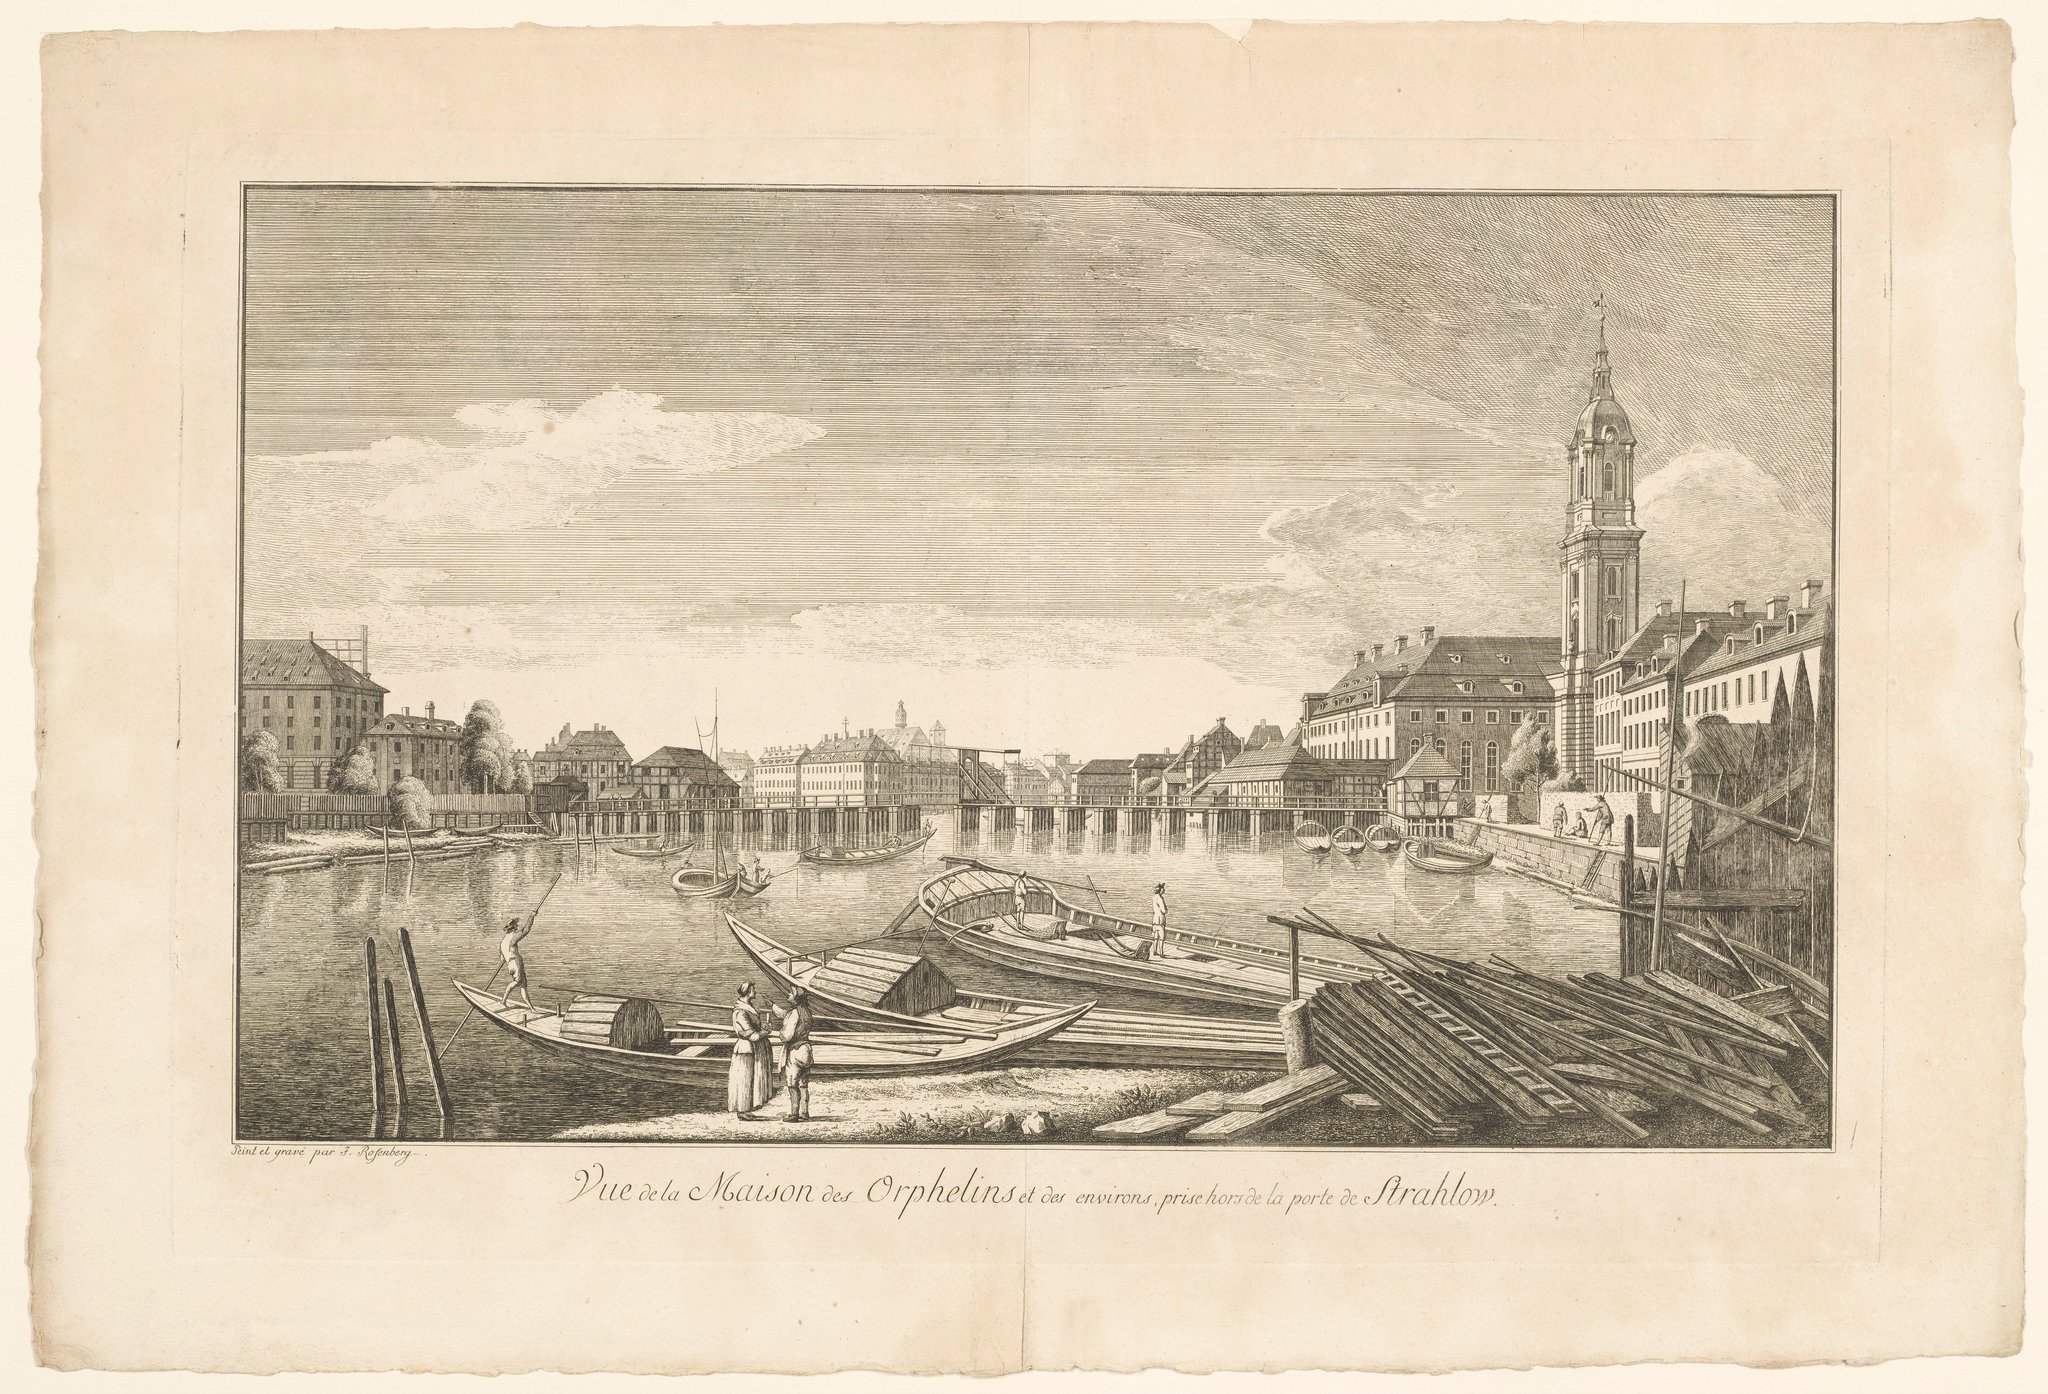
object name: print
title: Gezicht op het weeshuis van Berlijn, gezien vanaf de Strehlow-poort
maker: johann georg rosenberg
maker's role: print maker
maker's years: 1739-1808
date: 1749-1808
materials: paper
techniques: engraving, etching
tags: tower, clock tower ~ monumental adornment, city-view in general; 'veduta', quay, berlin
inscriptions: collector's mark: Lugt 2228